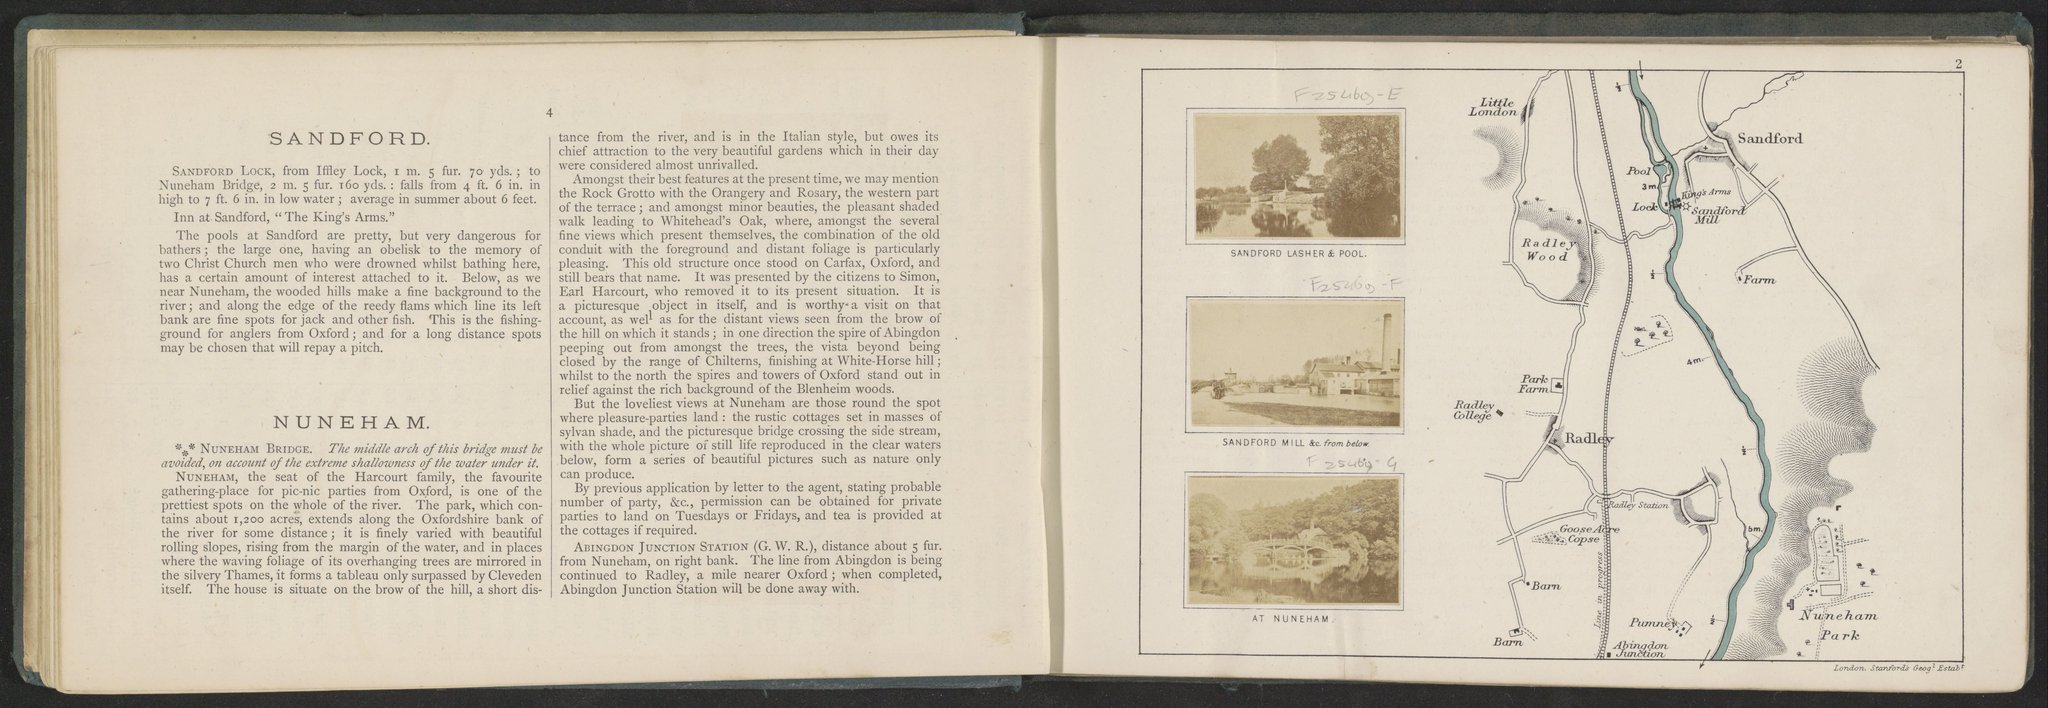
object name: page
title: At Nuneham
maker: henry w. taunt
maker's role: fotograaf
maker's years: 1842-1922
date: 1871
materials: photographic support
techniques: albumen print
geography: nuneham courtenay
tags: bridge, thames